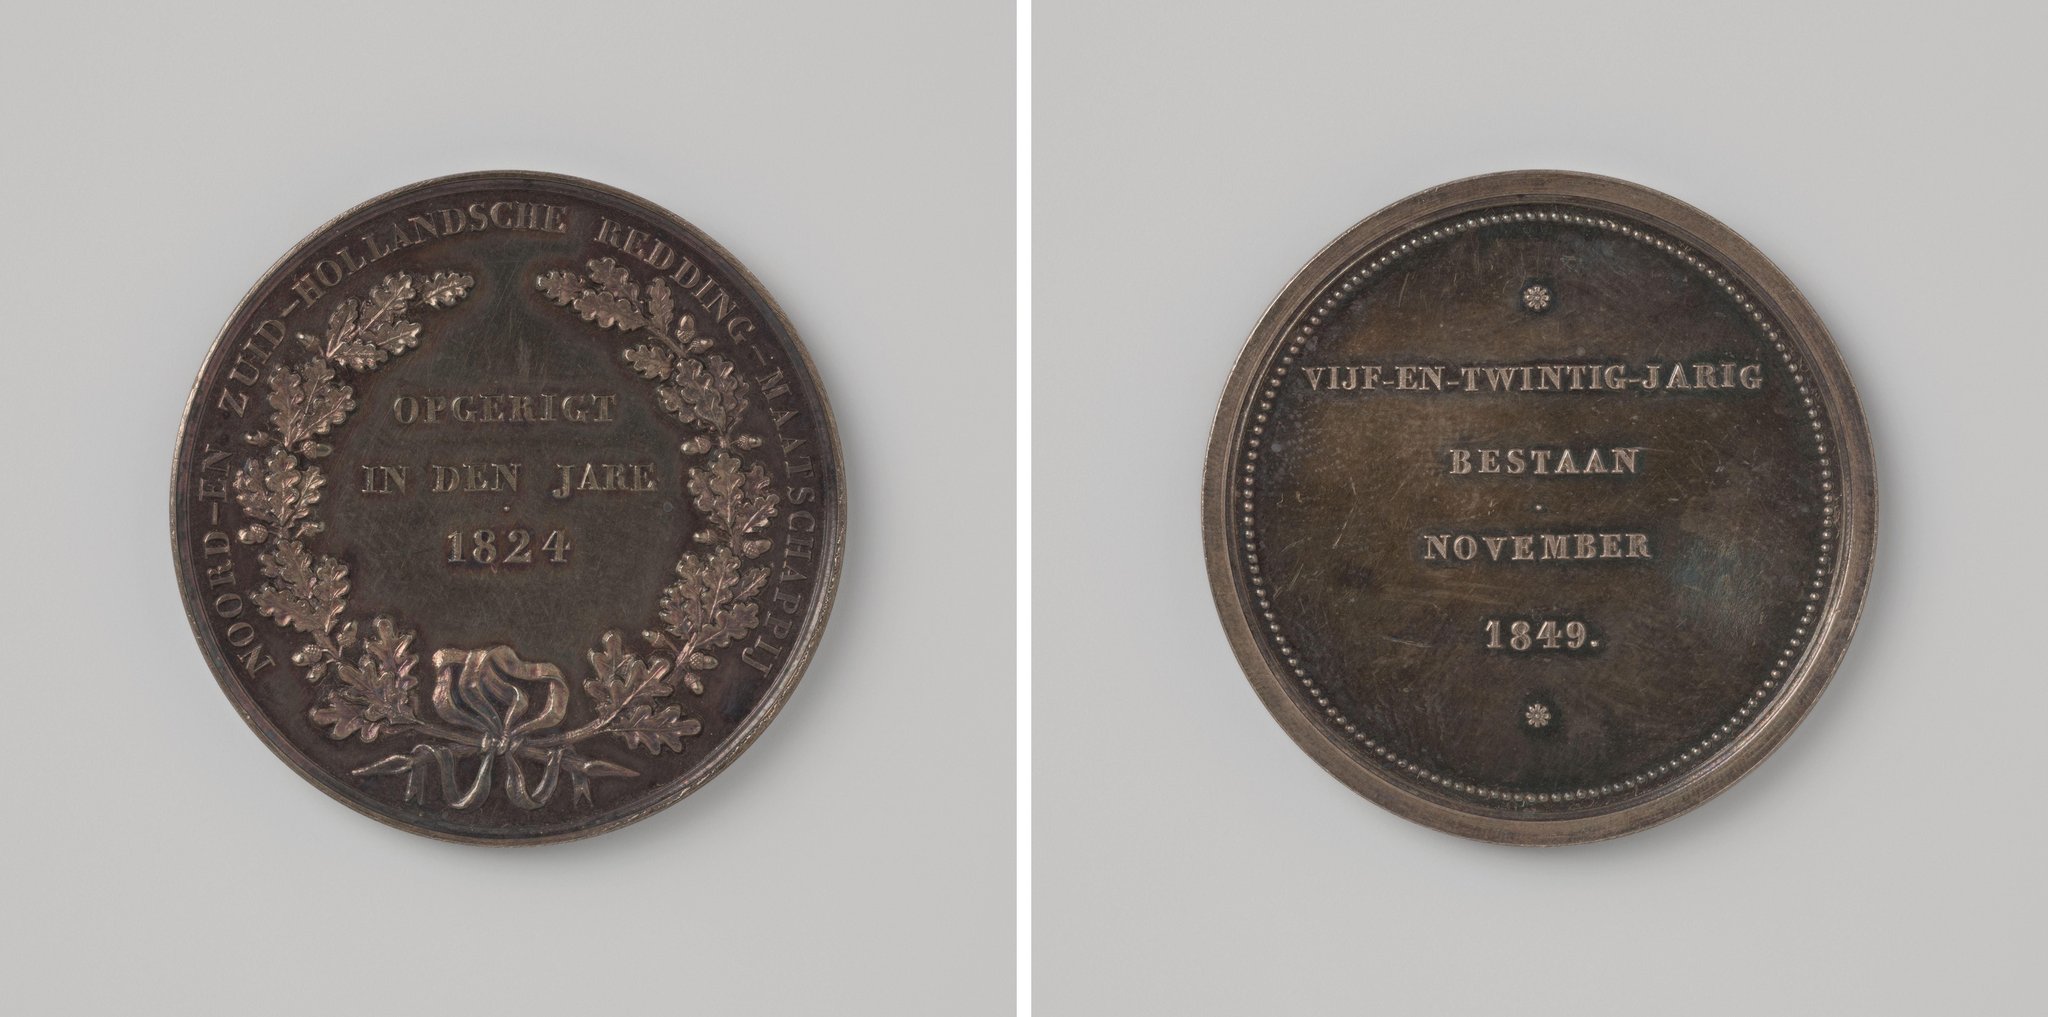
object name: history medal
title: Vijfentwintigjarig bestaan van de Noord- en Zuid-Hollandsche Redding-Maatschappij 1849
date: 1849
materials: silver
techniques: striking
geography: utrecht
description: Zilveren penning, op de voorzijde drie regels tekst tussen samengestrikte eikentakken, met omschrift, op de keerzijde vier regels tekst met onder en boven een rozet.